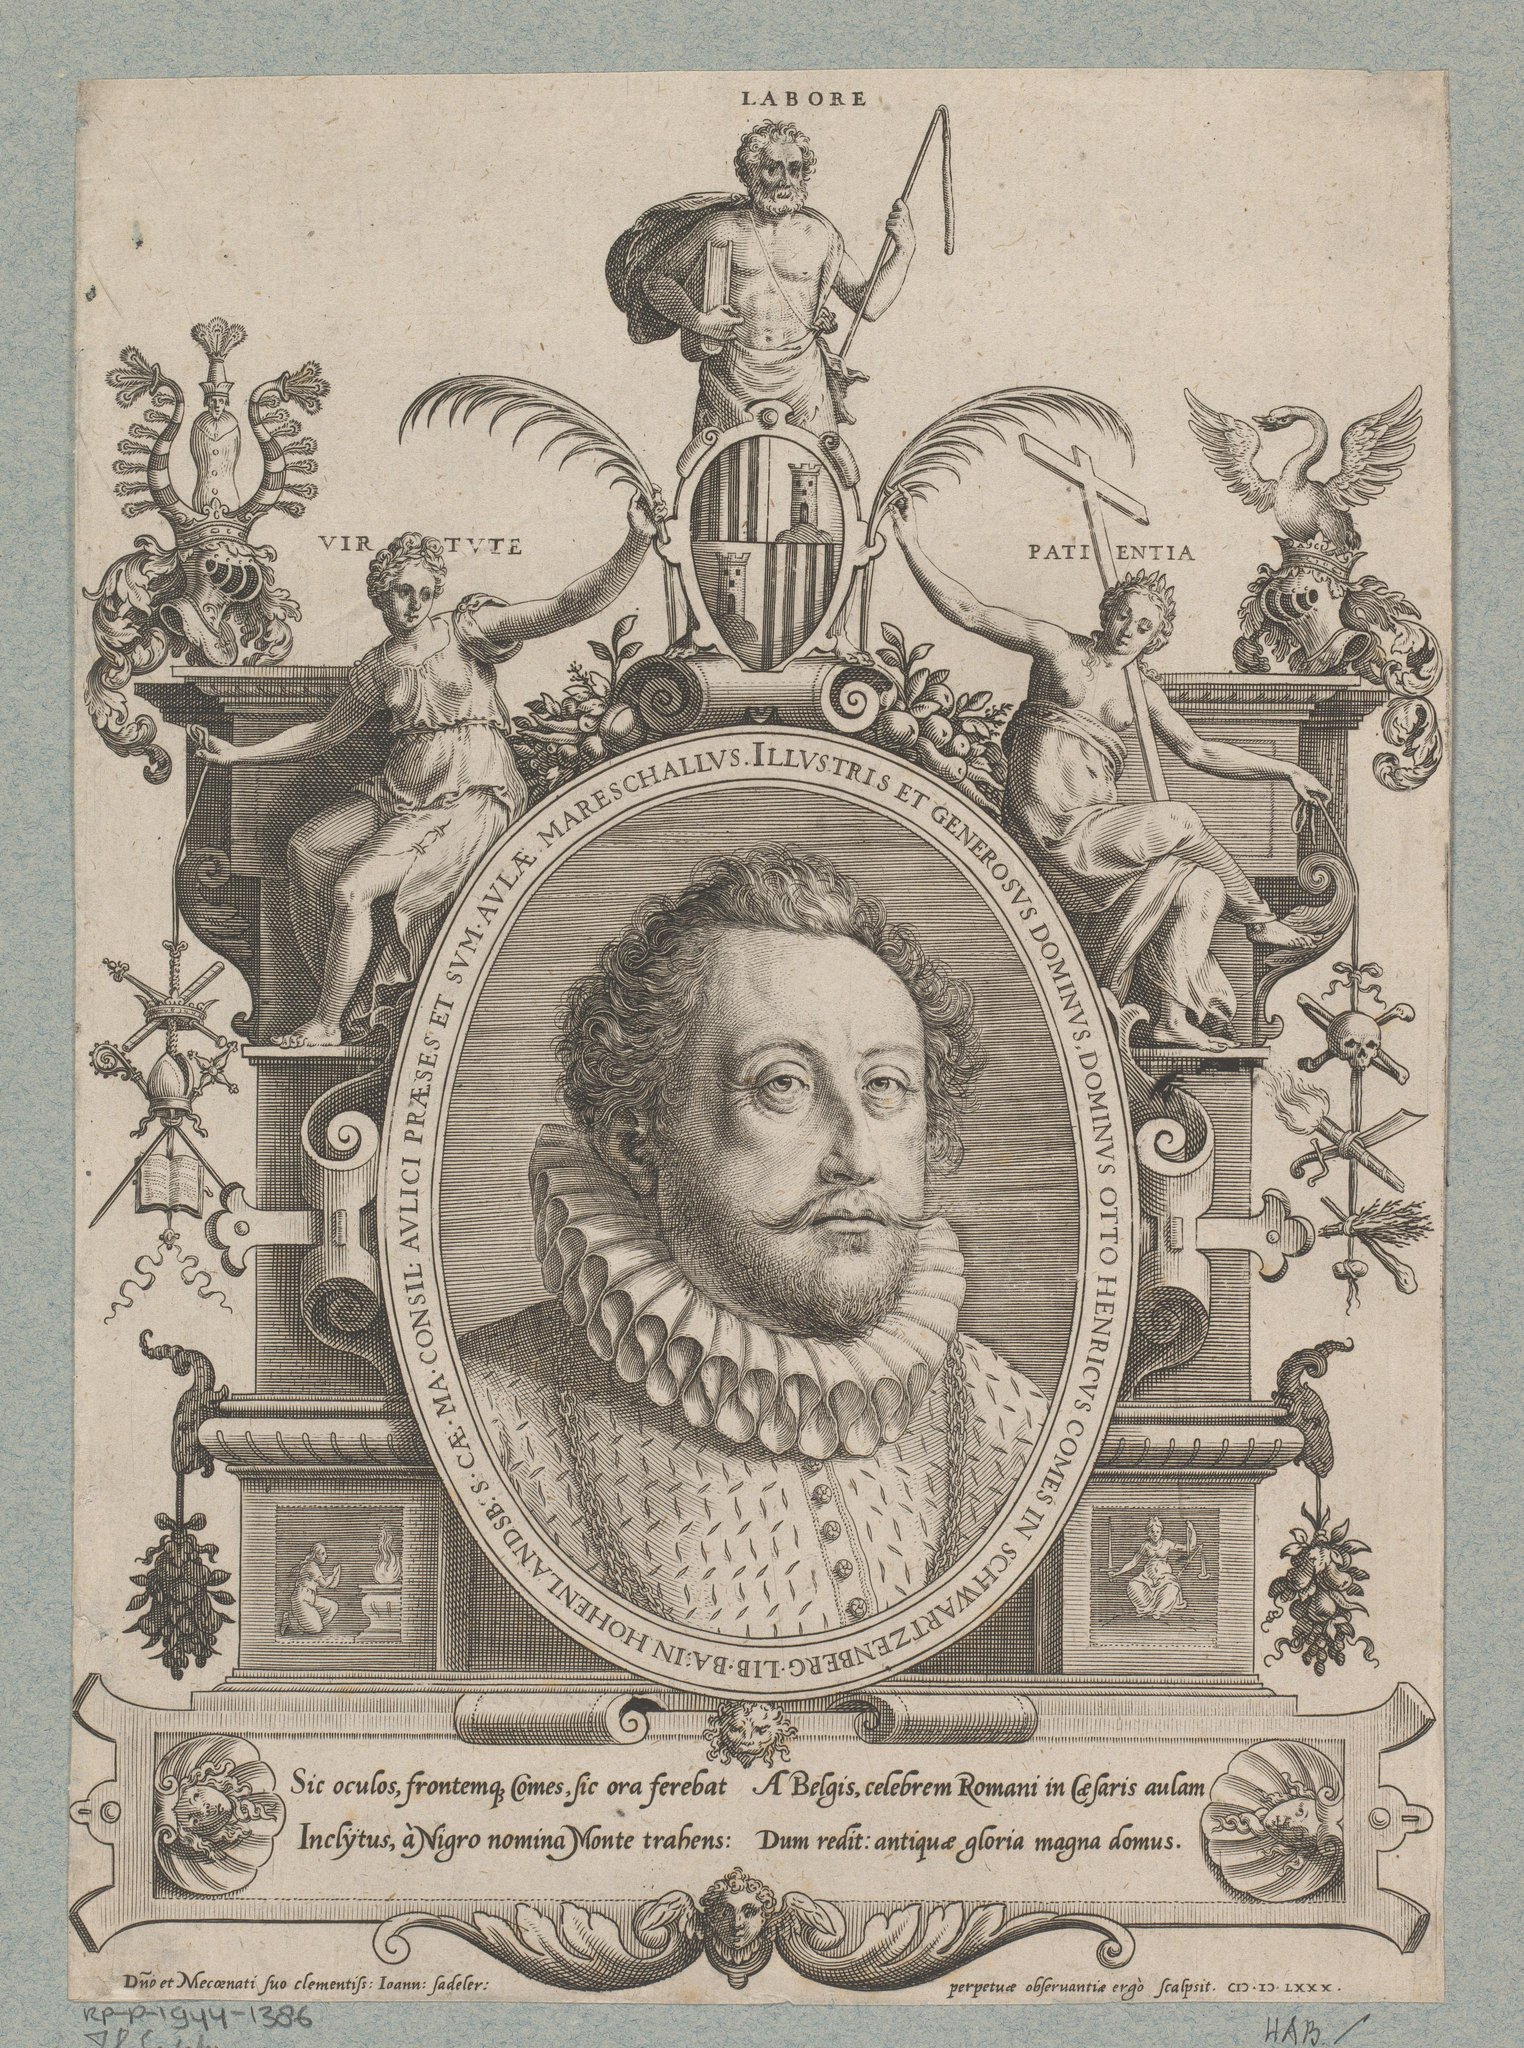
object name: print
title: Portret van Otto Heinrich von Schwarzenberg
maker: johann sadeler (i)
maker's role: print maker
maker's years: 1550-1600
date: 1580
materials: paper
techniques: engraving, etching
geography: cologne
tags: earl, politician, otto heinrich von schwarzenberg, historical persons, patience; 'patienza' (ripa), politician, e.g. party leader, virtuousness; 'amor di virtù', 'attione virtuosa', 'guida sicura de' veri honori', 'virtù', 'virtù insuperabile' (ripa), labour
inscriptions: collector's mark: Lugt 2228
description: Met tweeregelig onderschrift in het Latijn en tekst in het Latijn rondom het portret.